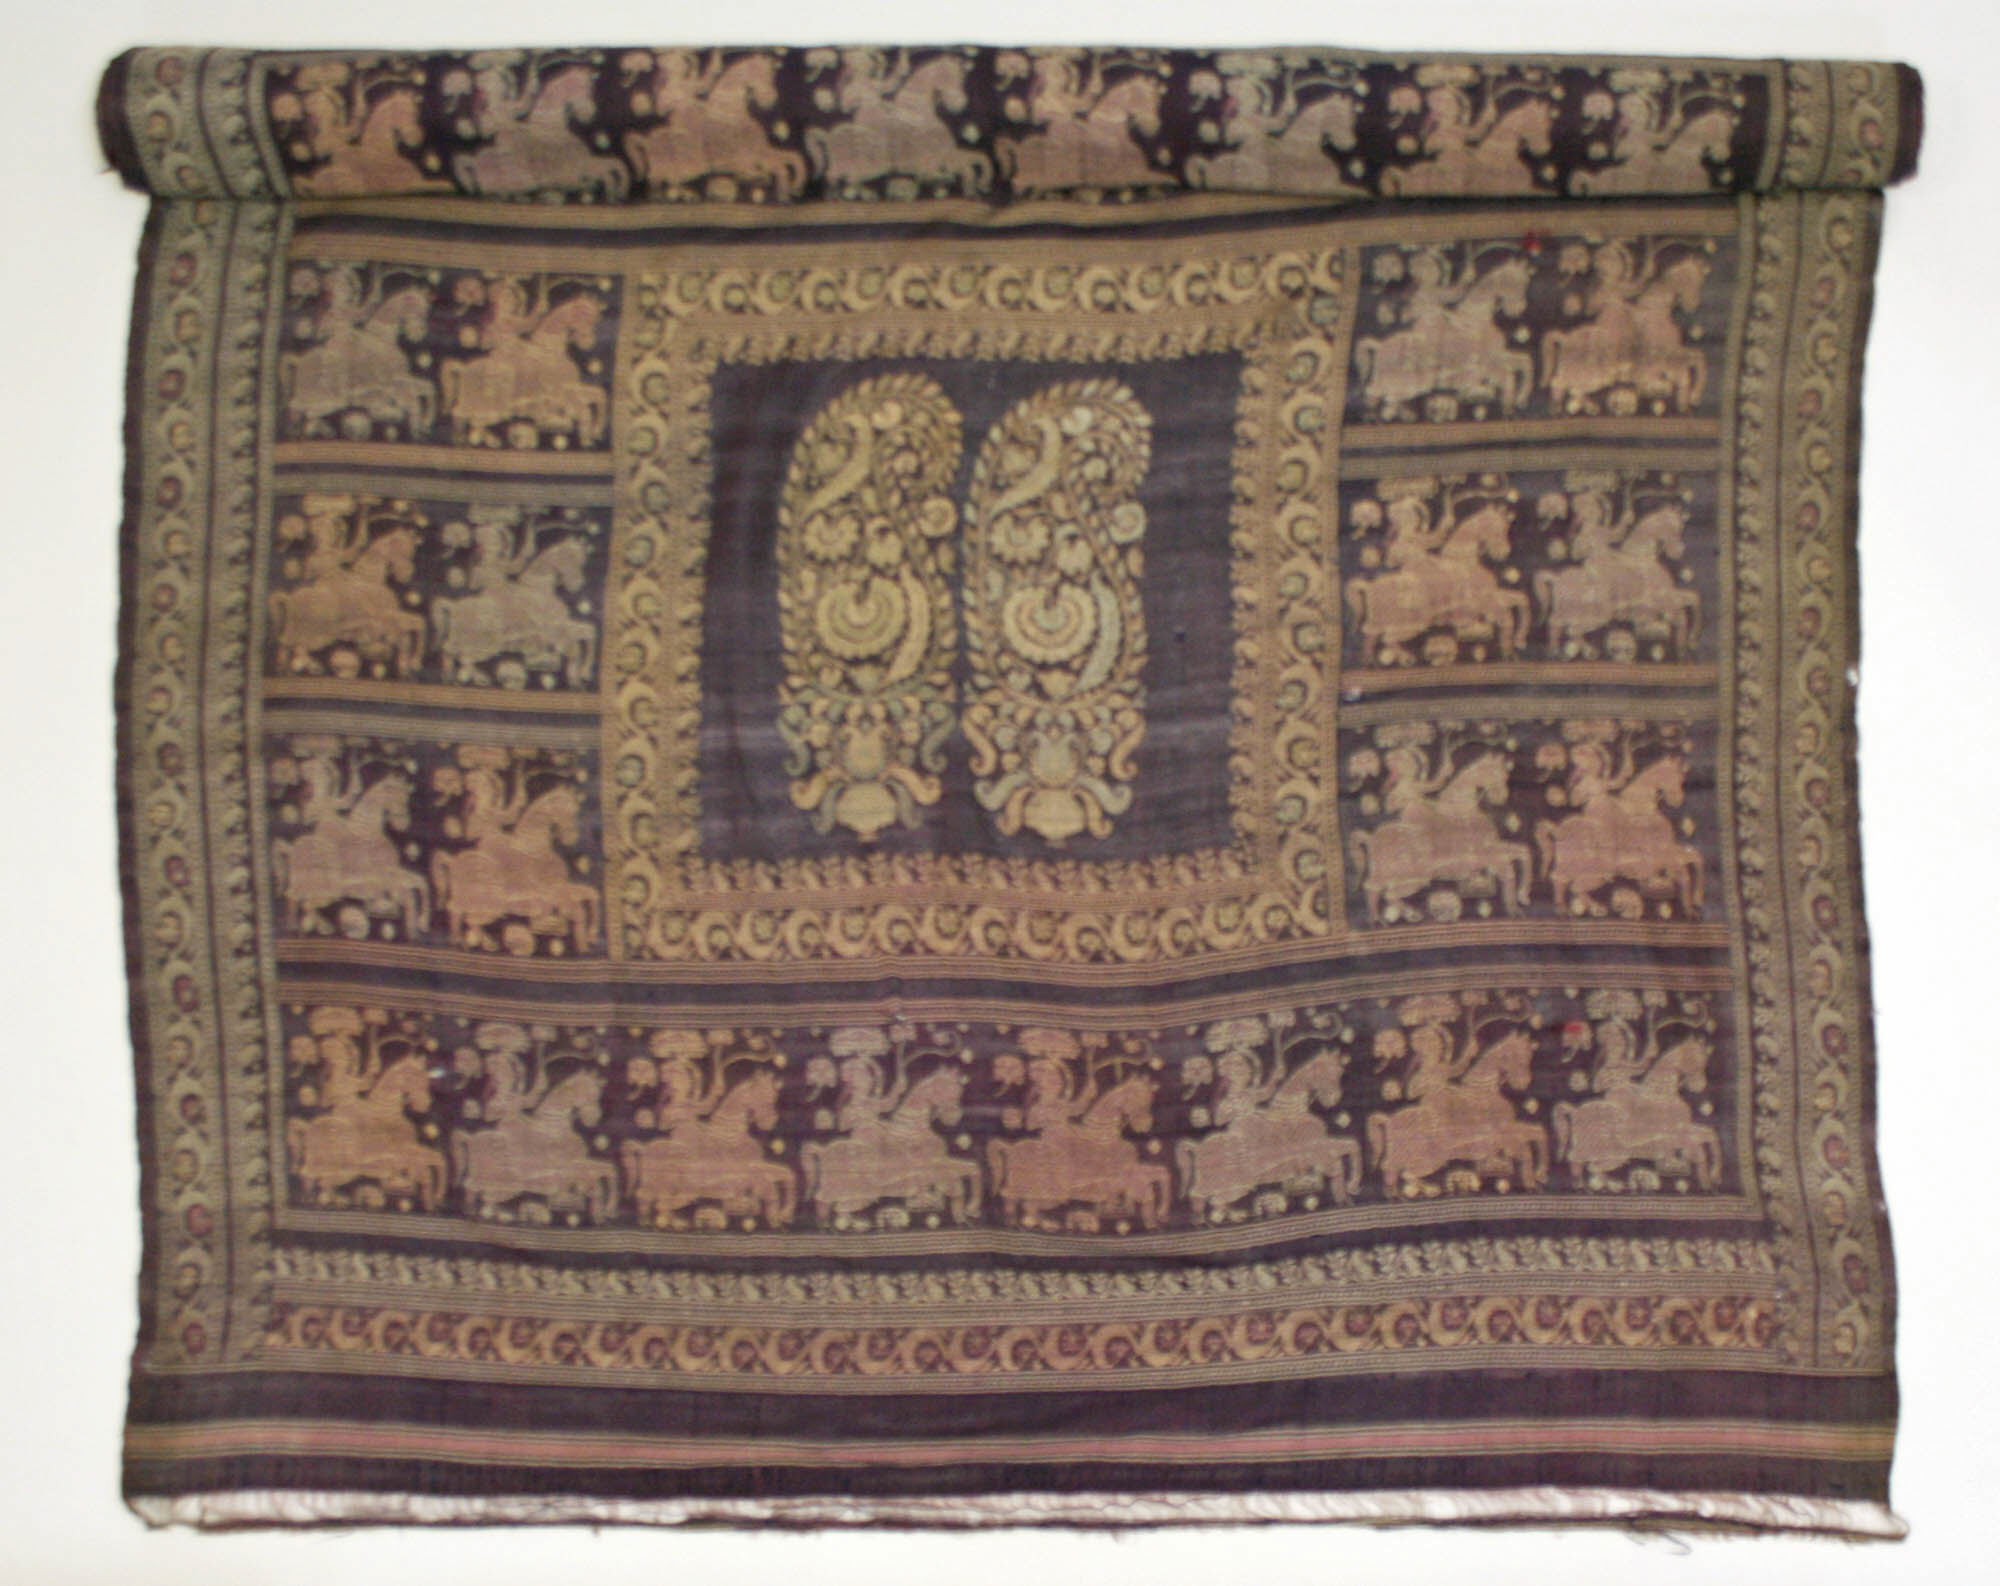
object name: sari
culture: indian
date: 1701-1800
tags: horses